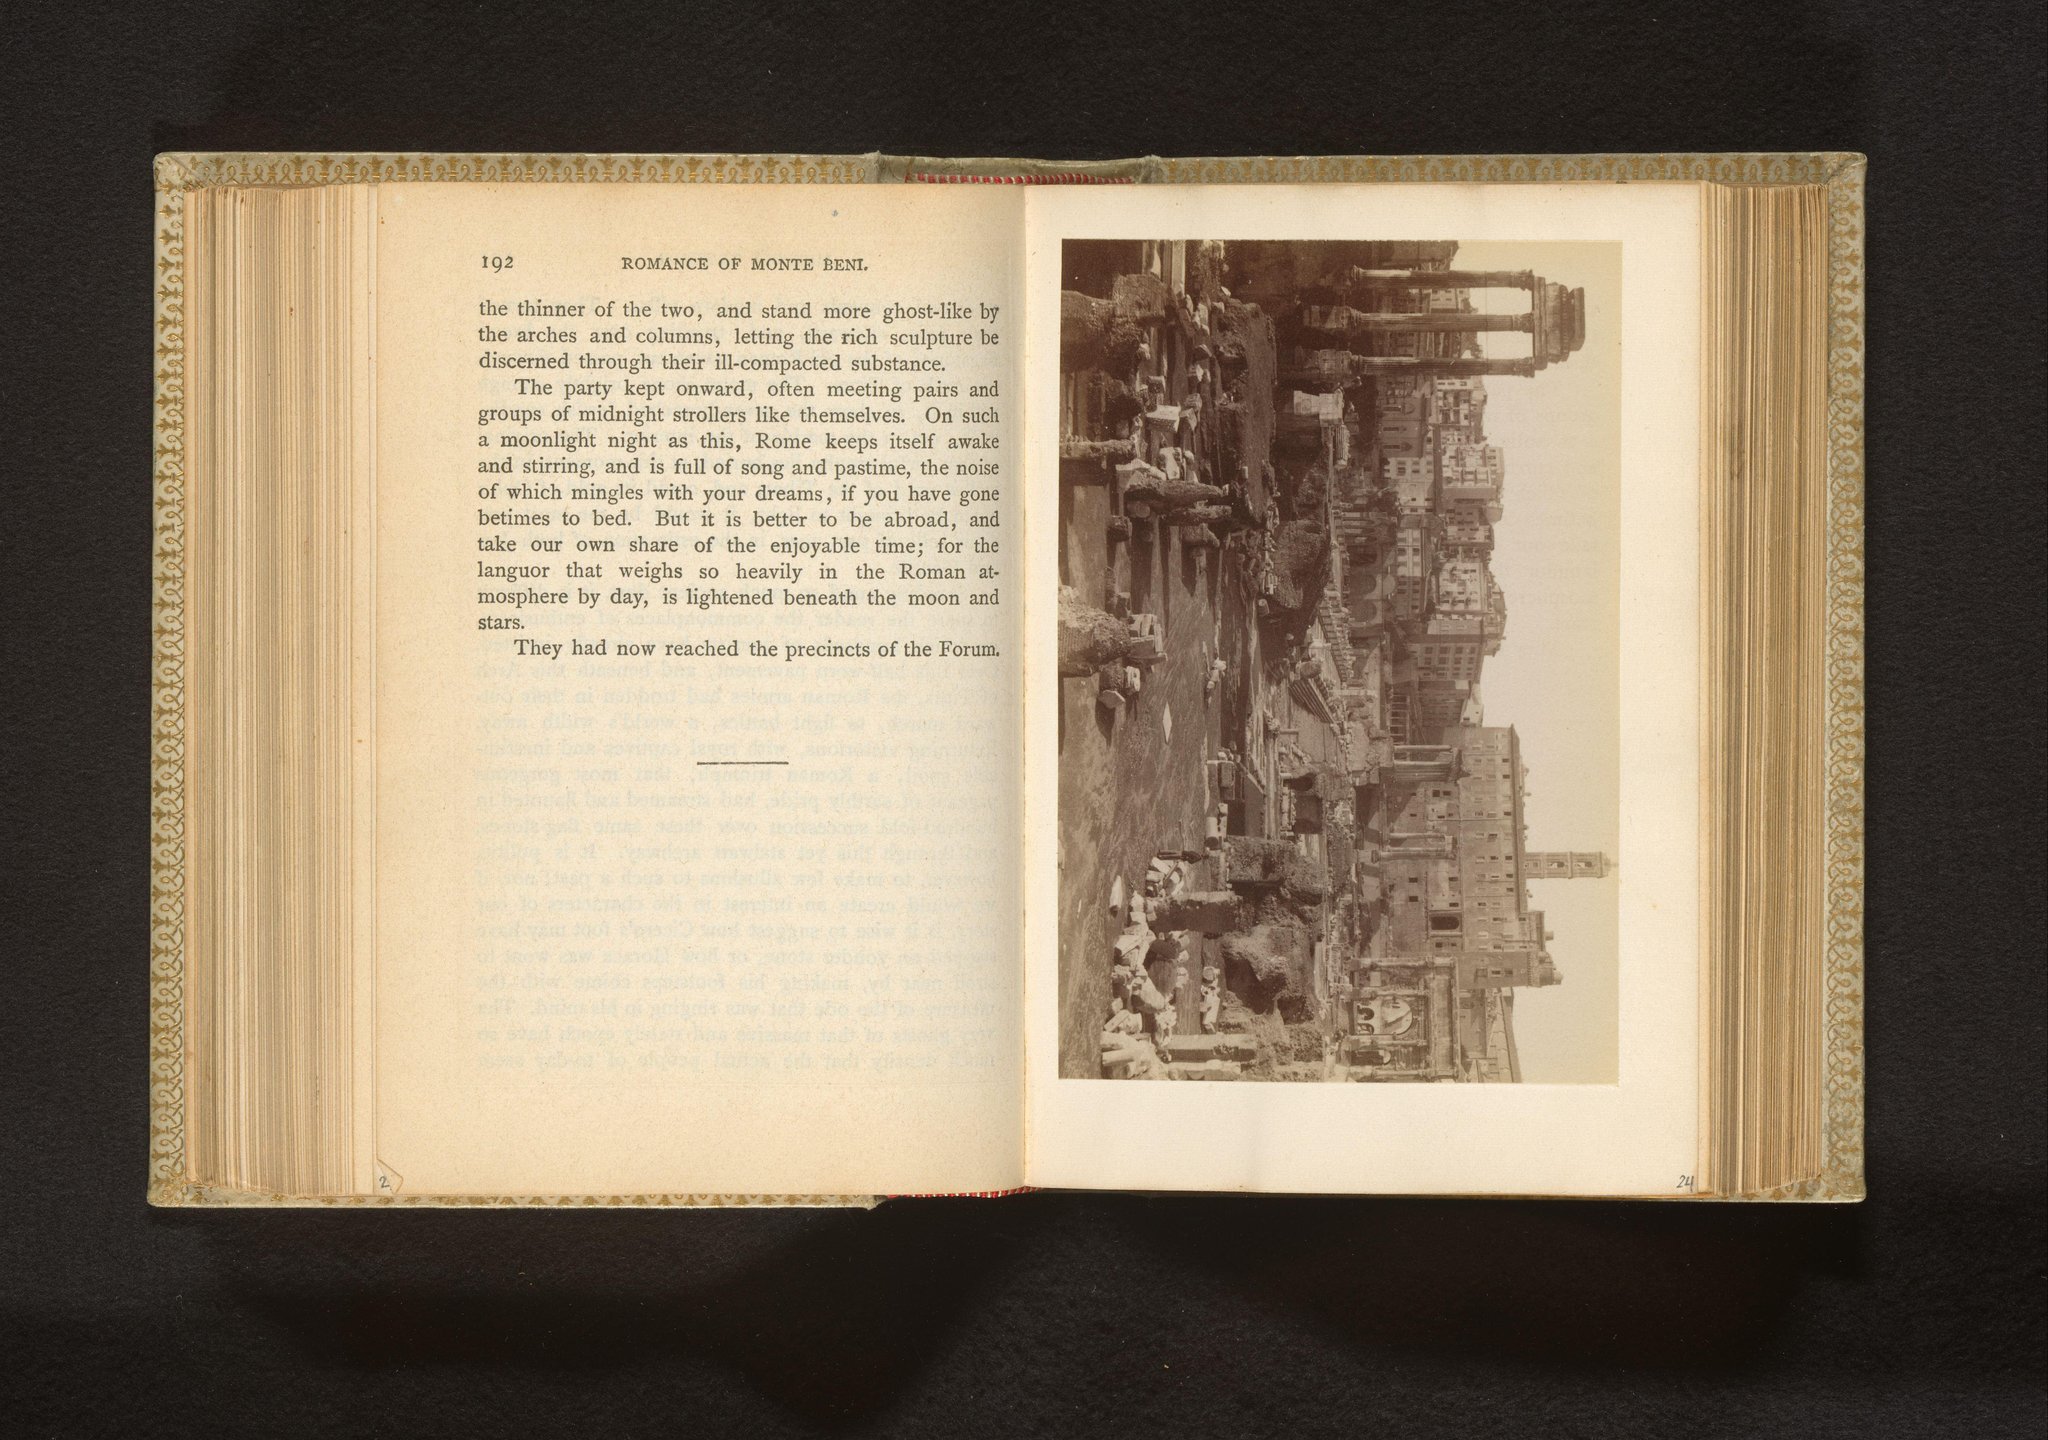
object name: page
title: Gezicht op het Forum Romanum in Rome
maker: Anonymous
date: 1850-1860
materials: photographic support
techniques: albumen print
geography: rome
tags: landscape with ruins